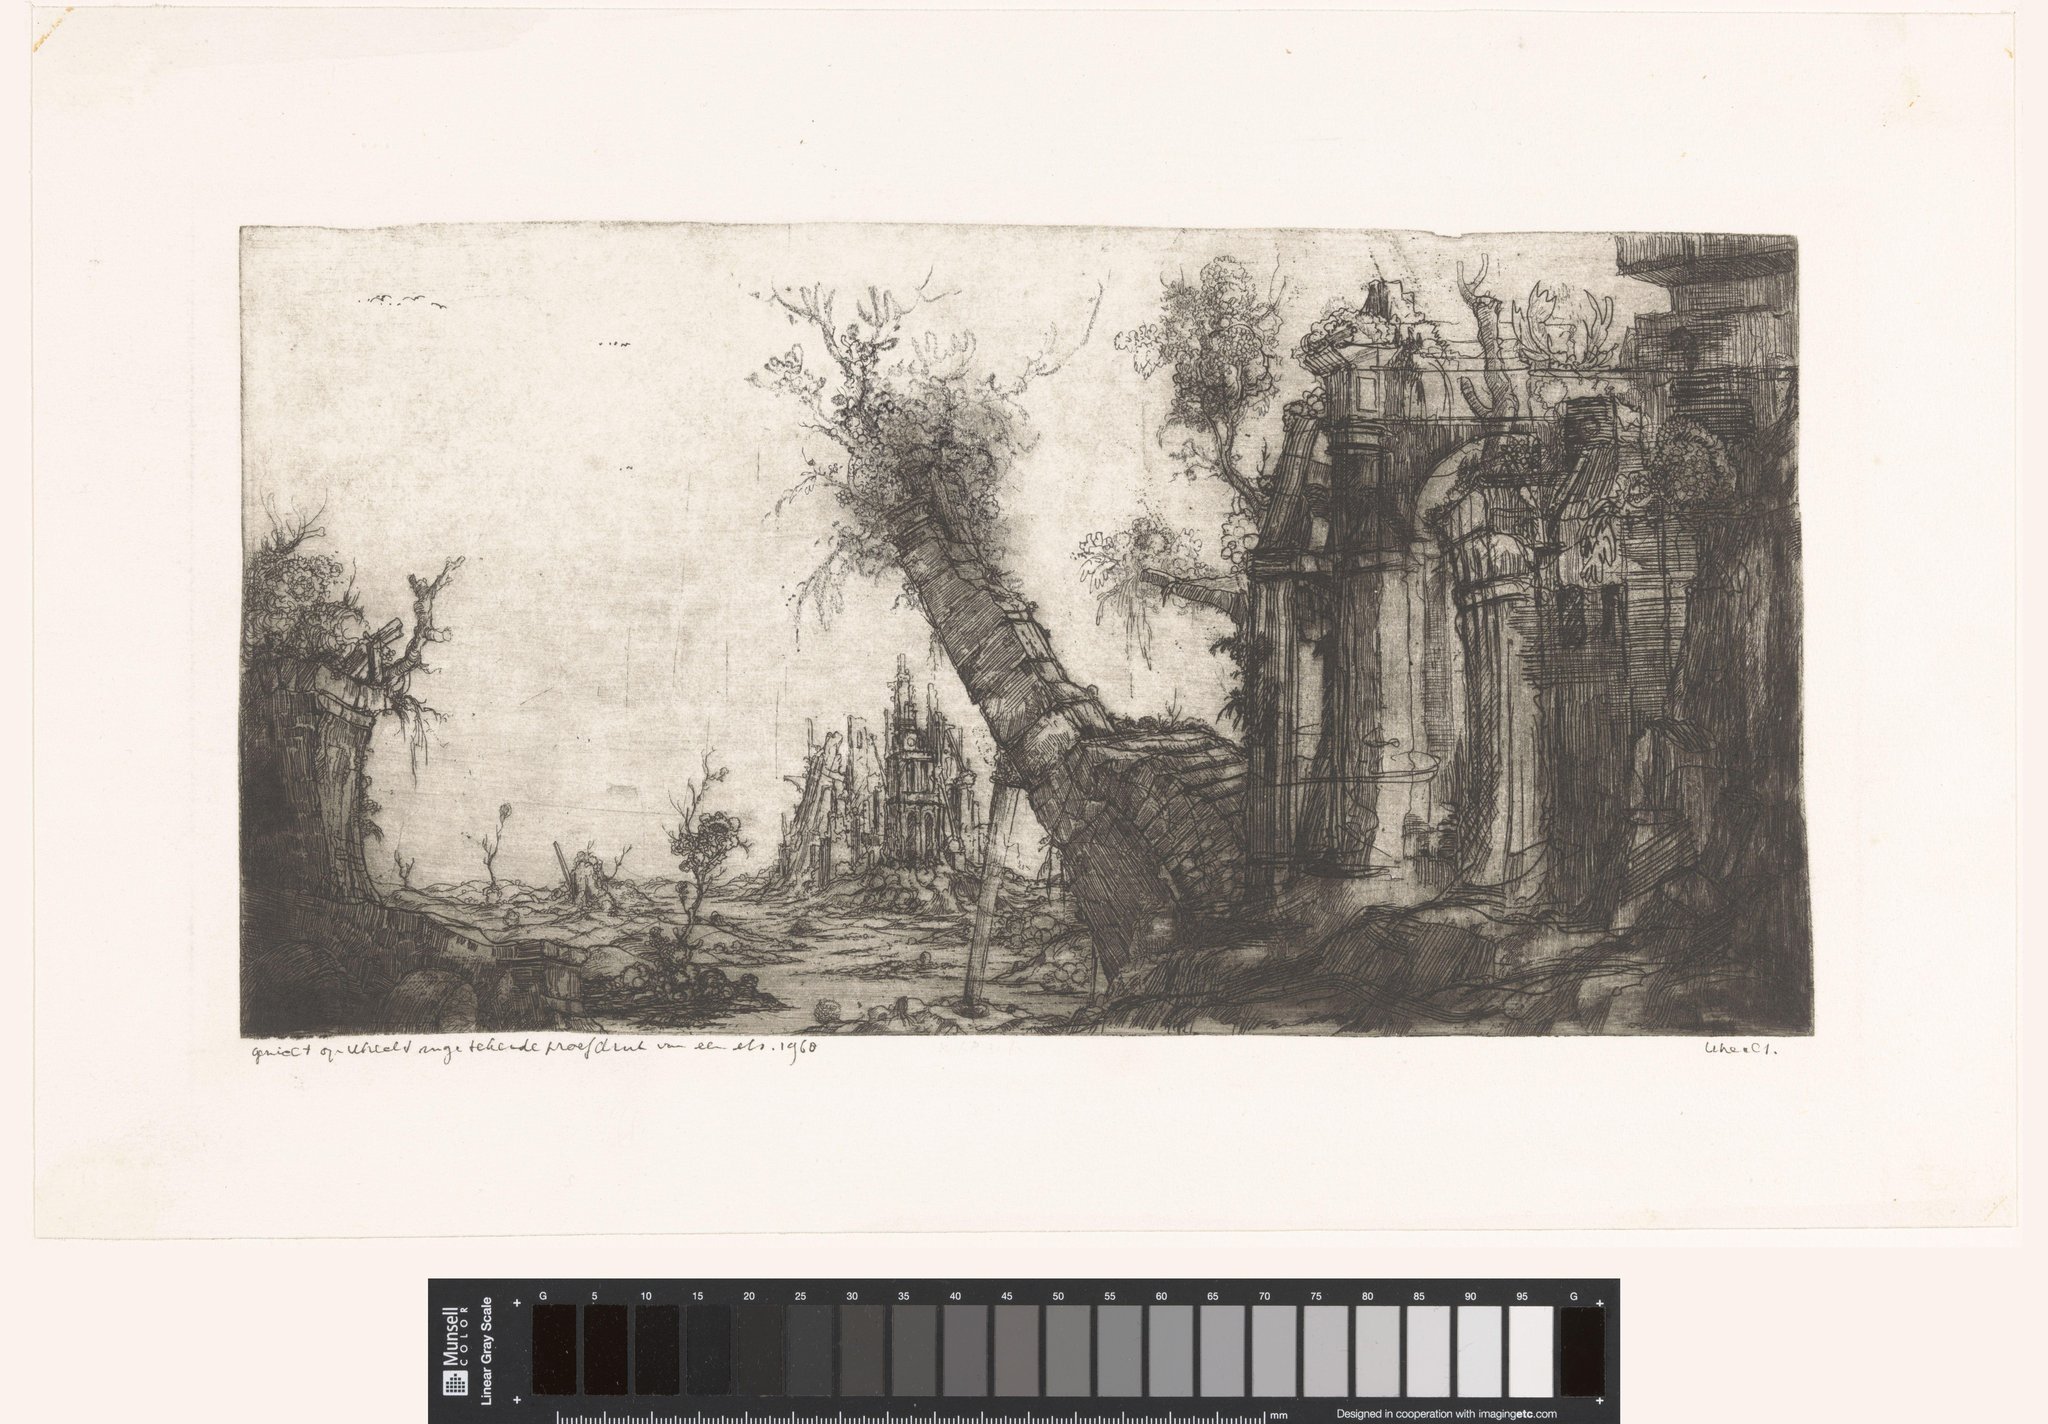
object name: print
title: Gezicht op Utrecht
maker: dirkje kuik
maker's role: print maker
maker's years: 1929-2008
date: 1968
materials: ink, paper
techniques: etching, pen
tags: utrecht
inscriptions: inscription: ‘gezicht op Utrecht ingetekende proefdruk van een ets. 1968’, inscription: ‘Utrecht’